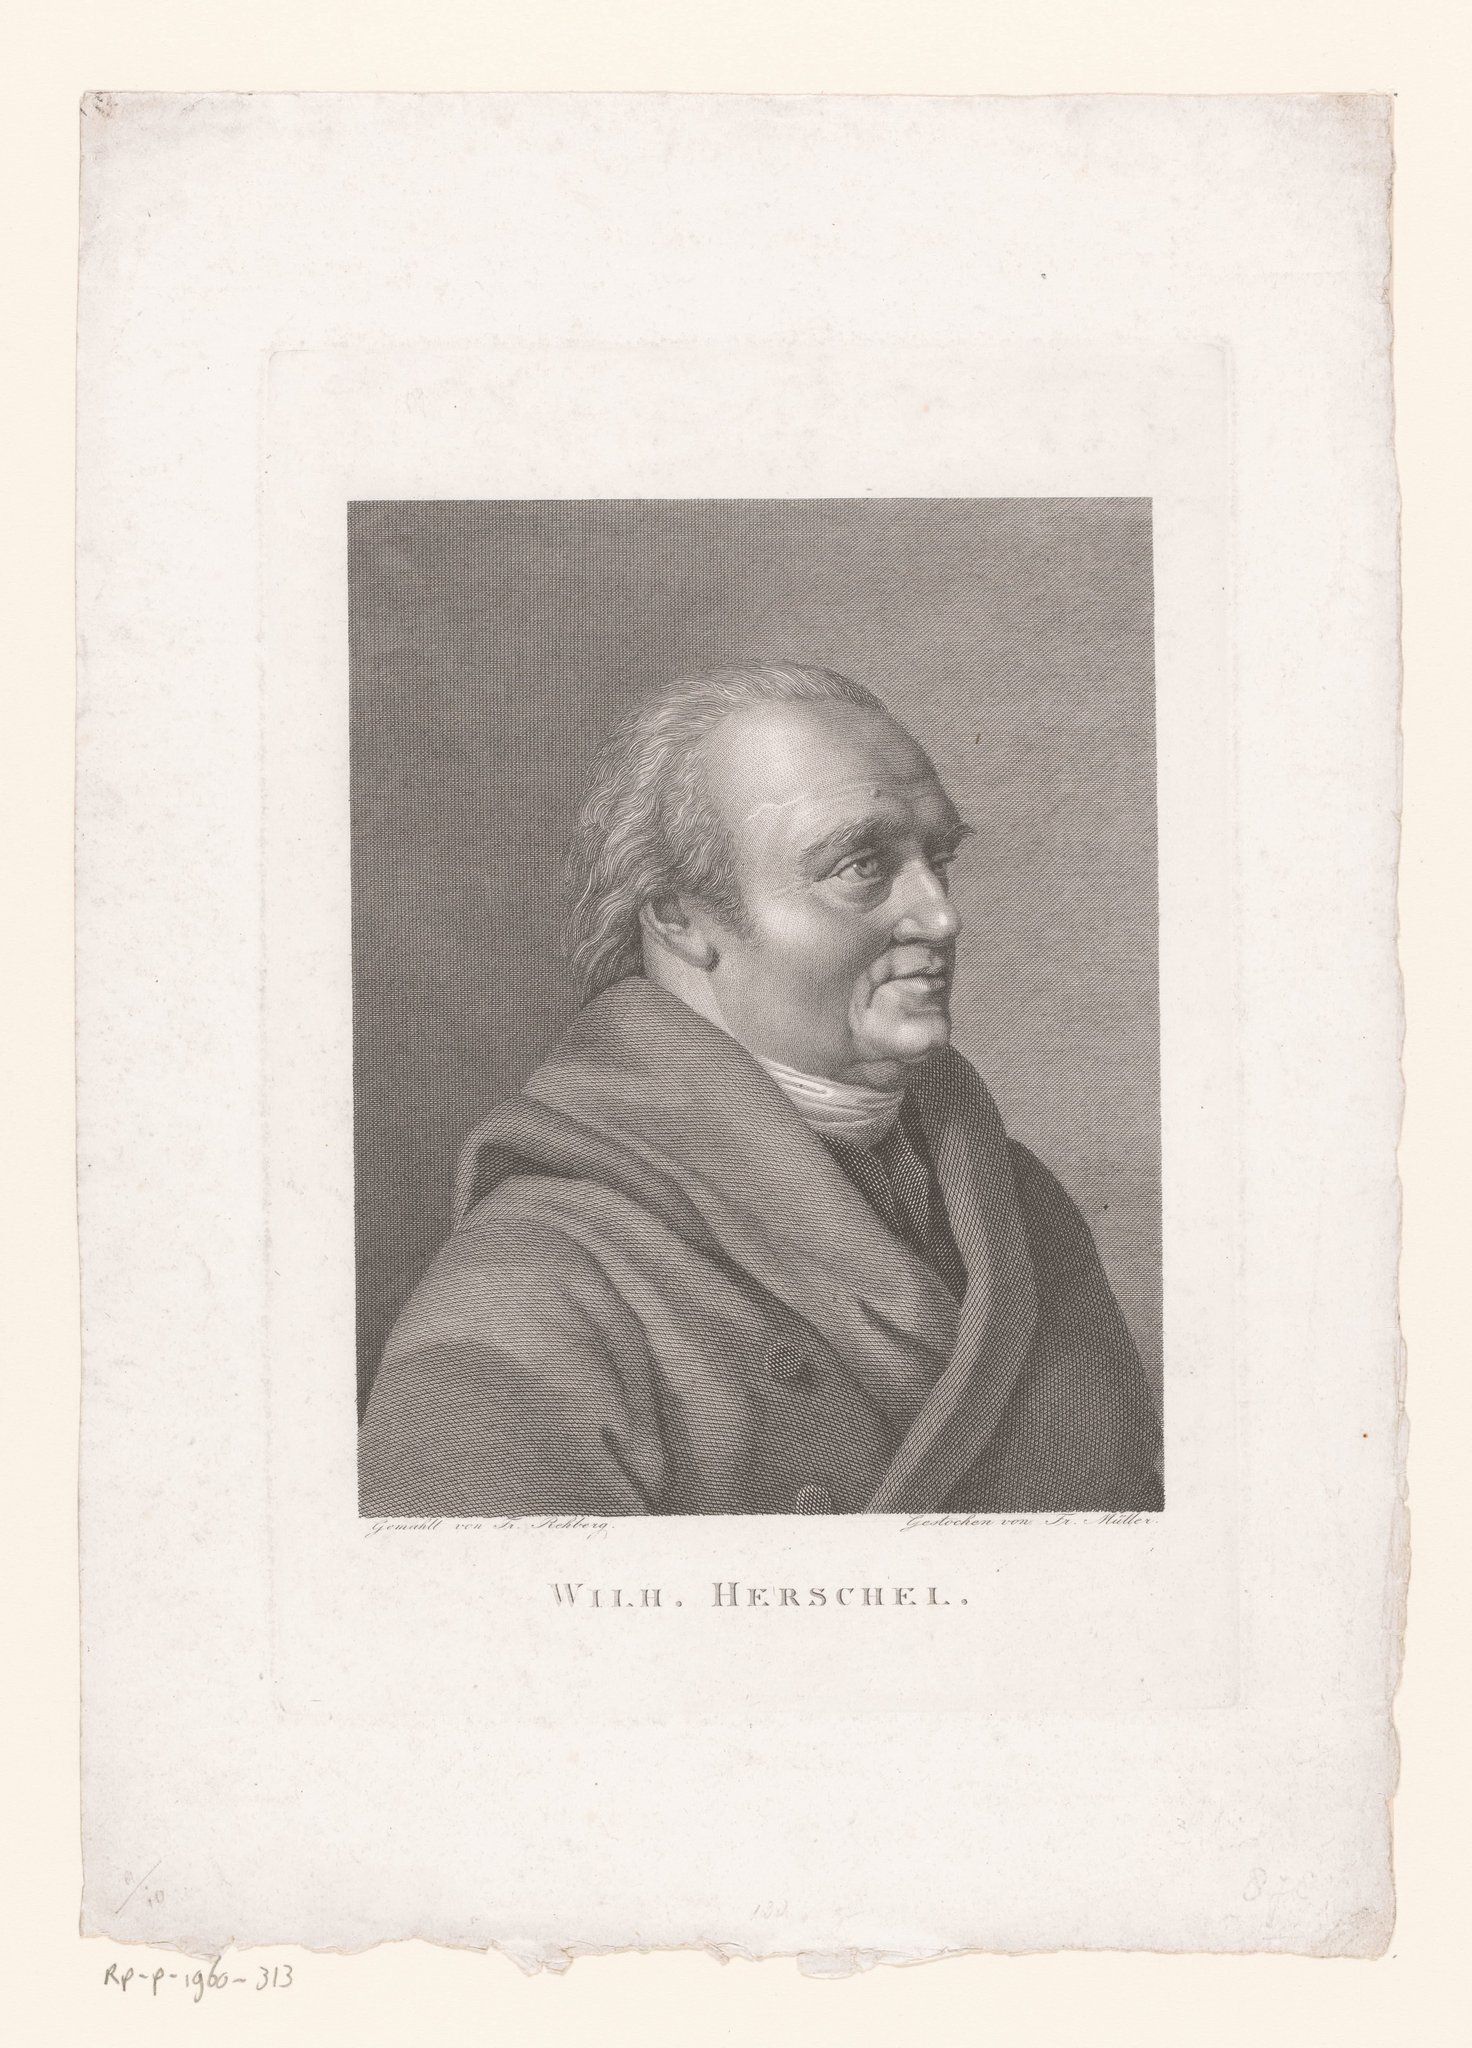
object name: print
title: Portret van Frederick William Herschel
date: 1792-1816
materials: paper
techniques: engraving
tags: england, historical persons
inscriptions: collector's mark: Lugt 2228